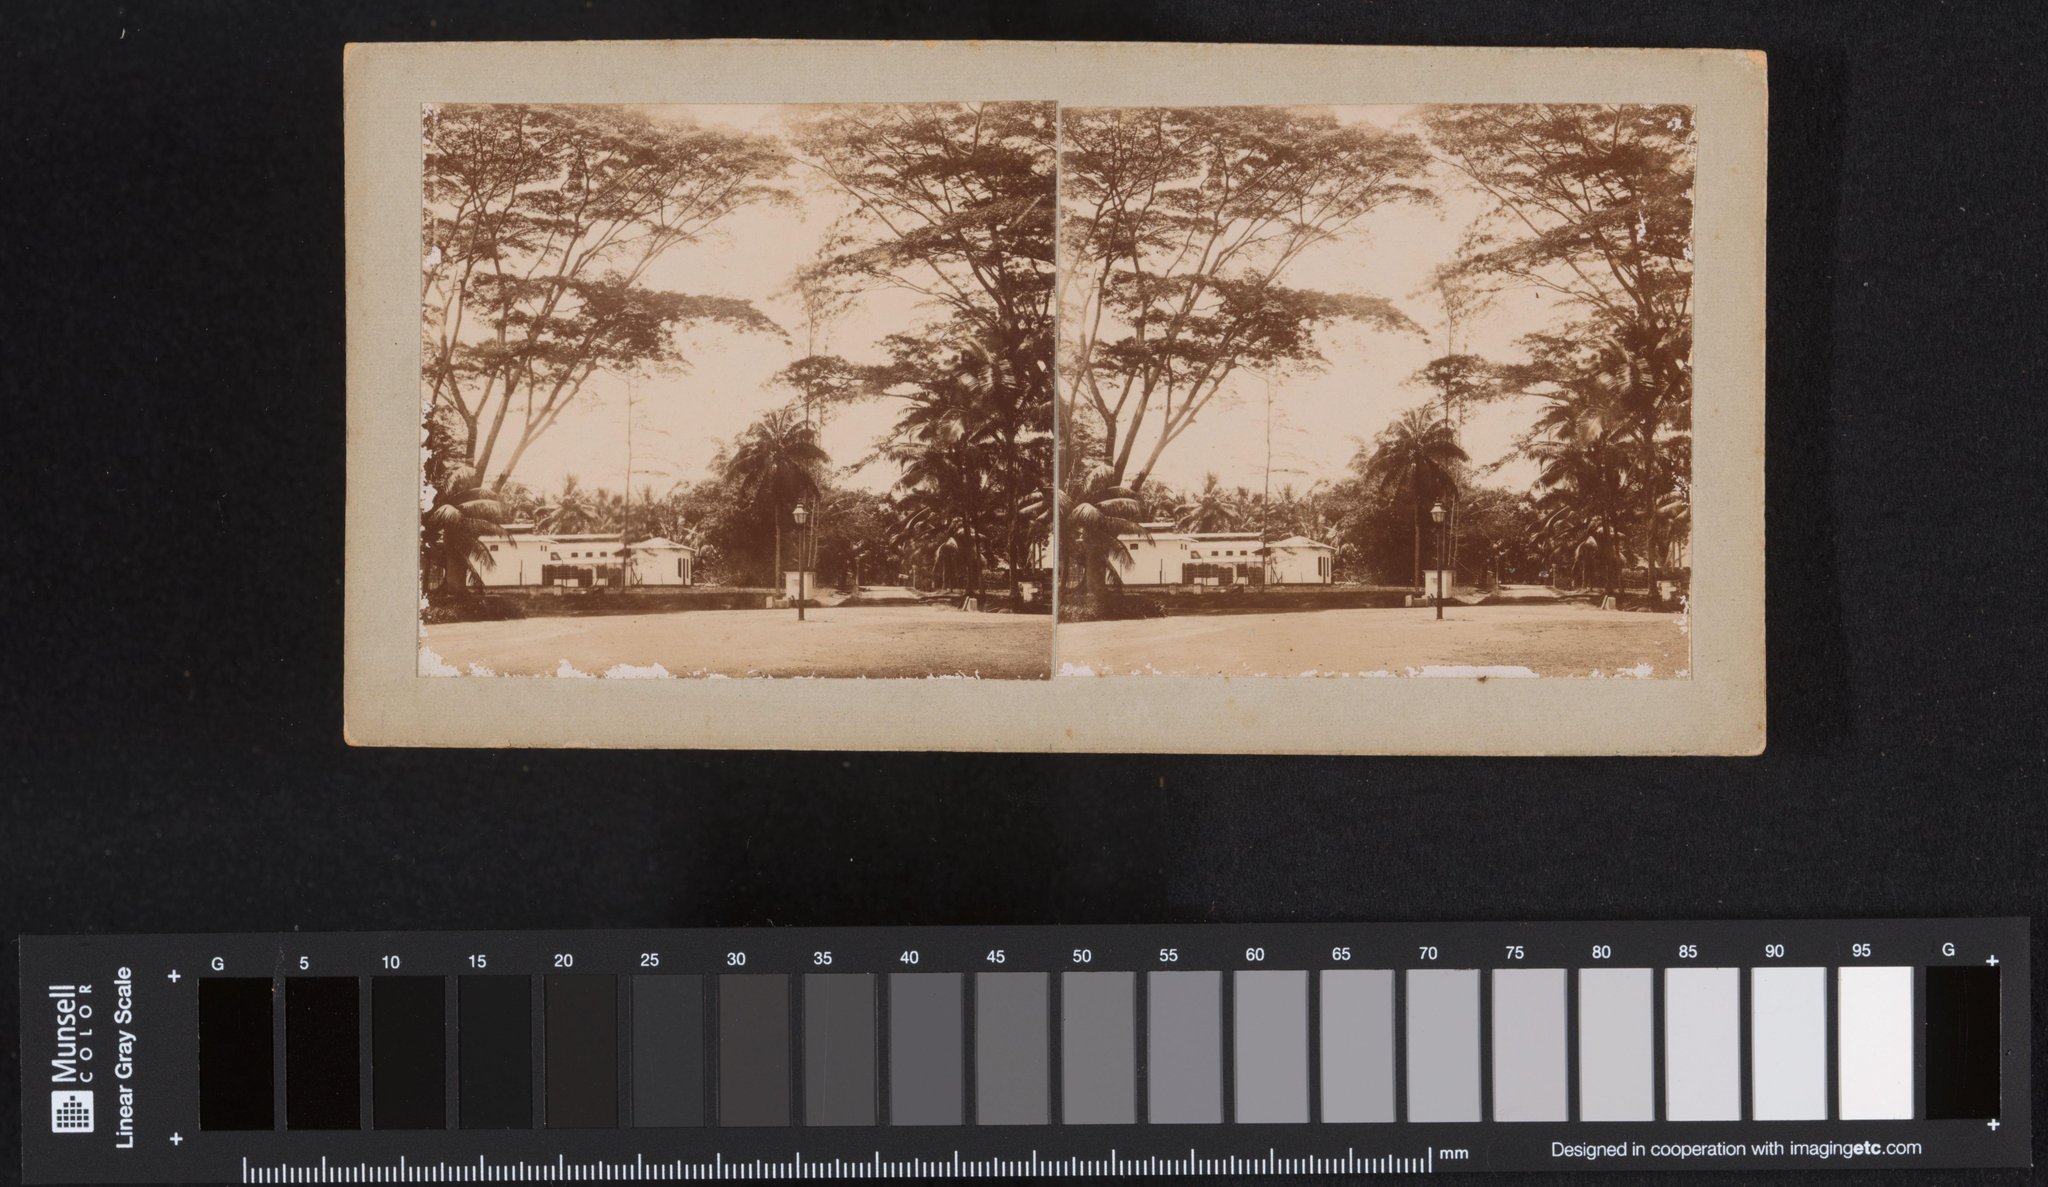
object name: stereograph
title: Gevangenis te Soengeiliat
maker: robert julius boers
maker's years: 1867-1932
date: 1900-1922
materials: cardboard, photographic support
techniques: gelatin silver print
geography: bangka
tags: robert julius boers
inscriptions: inscription: ‘Gevangenis te Soeng ei kiat’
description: Gezicht op de gevangenis van Soengeiliat op Banka. Onderdeel van een groep stereofoto's van Robert Julius Boers, chef van het staatsbedrijf de Banka-tinwinning op Banka, uit de periode ca. 1900-1922.